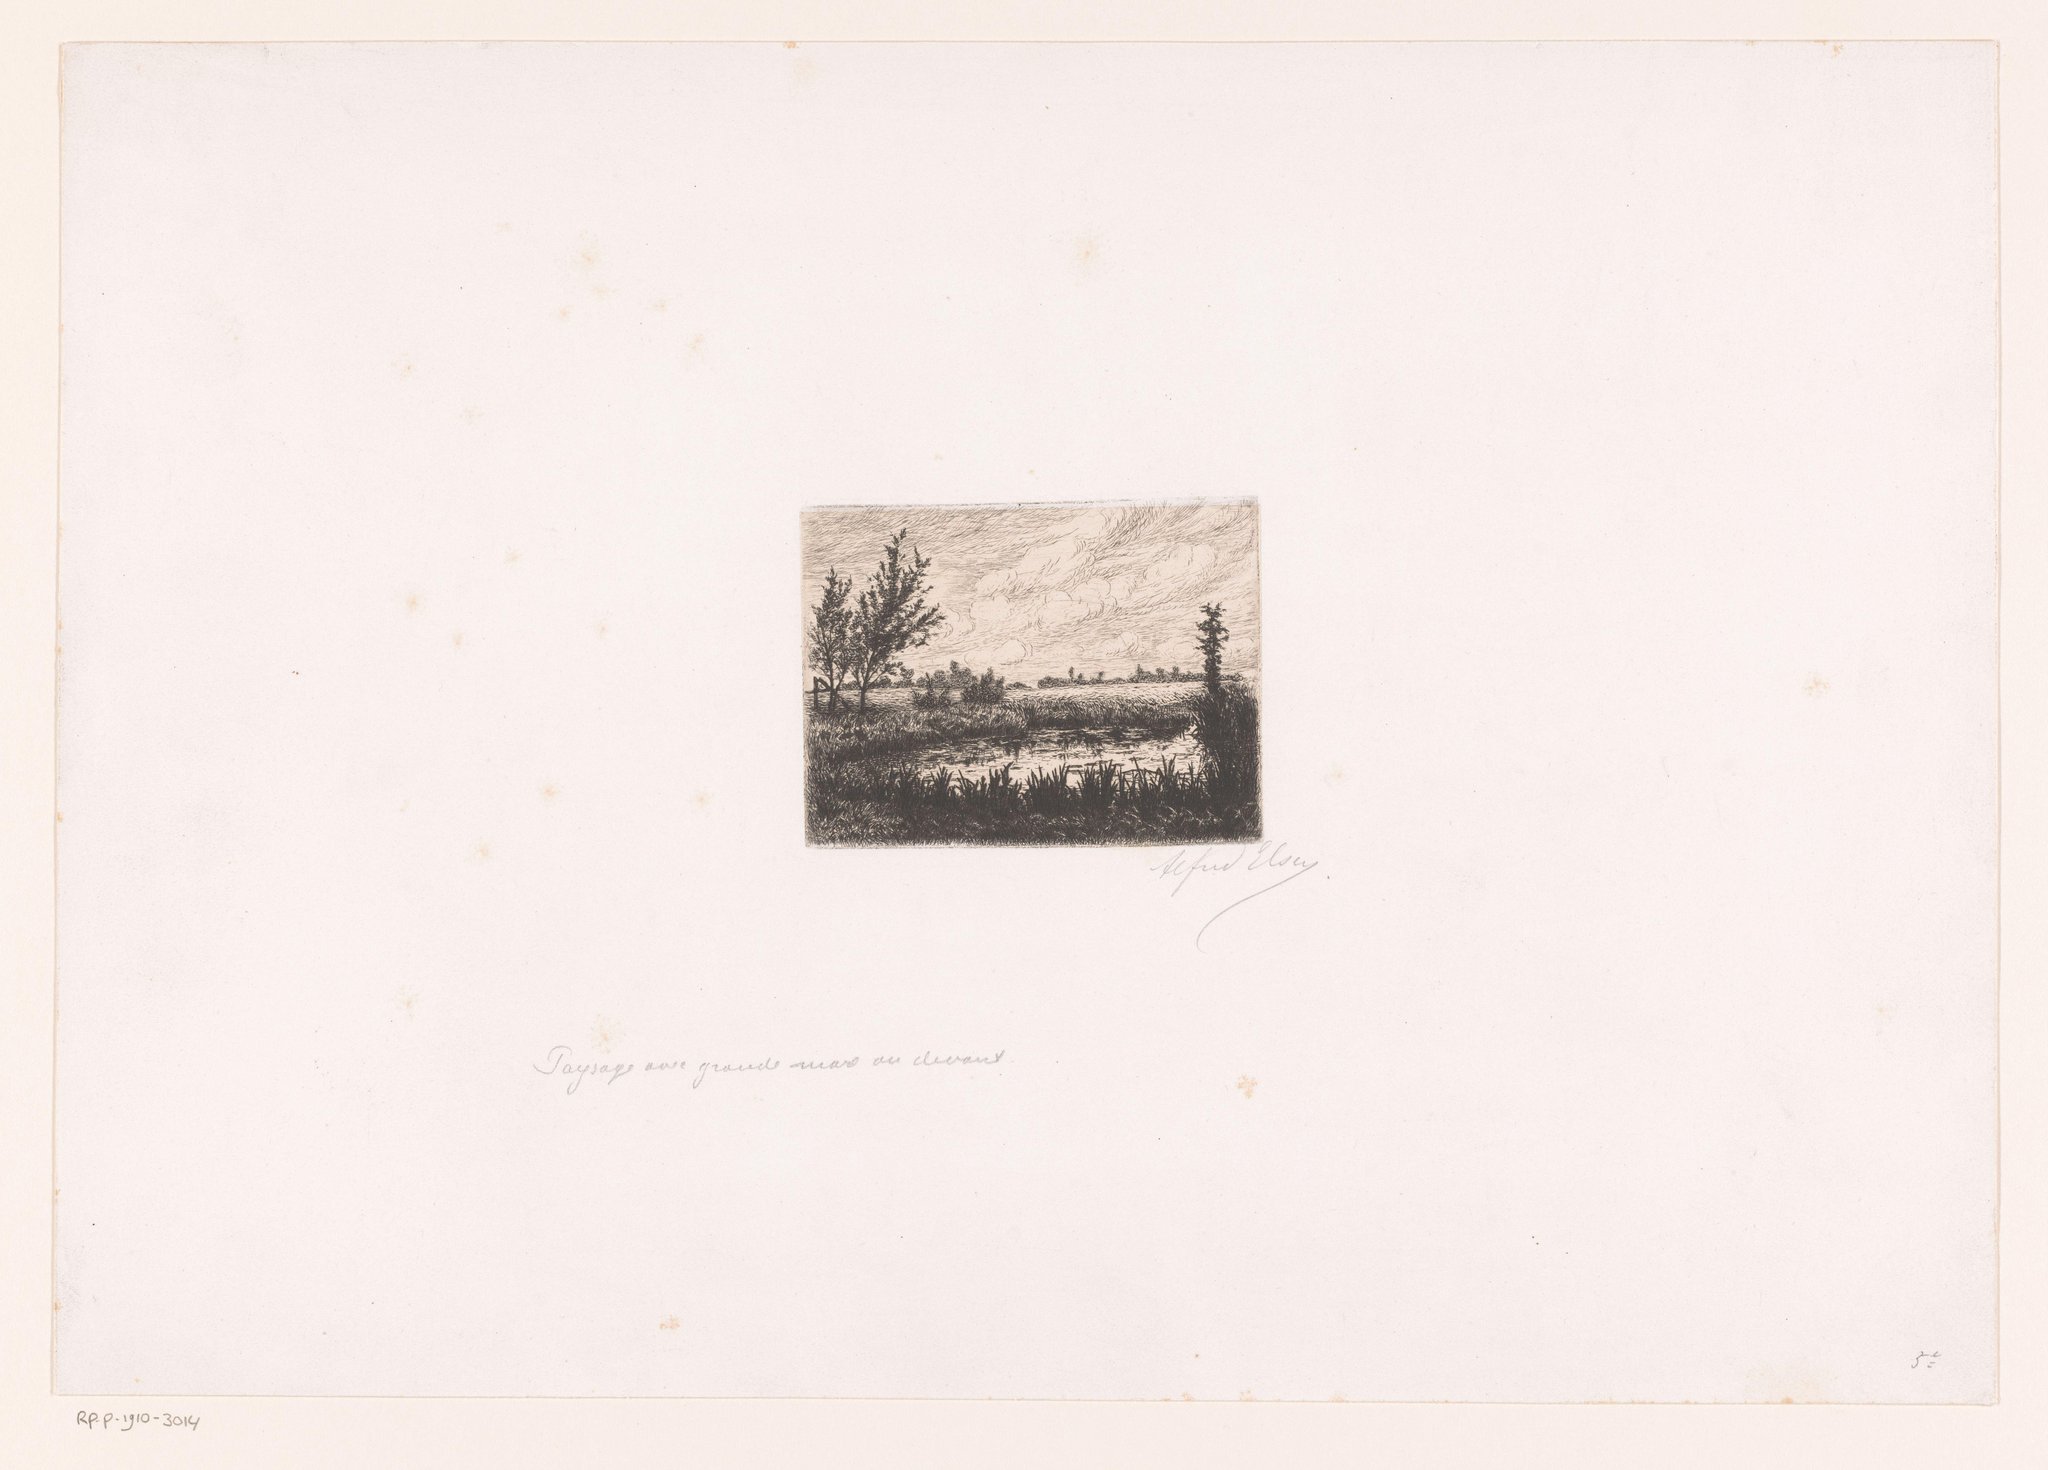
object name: print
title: Landschap met waterplas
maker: alfred elsen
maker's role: painter, print maker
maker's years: 1850-1914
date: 1860-1910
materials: paper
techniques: etching, intaglio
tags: lake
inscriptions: collector's mark: Lugt 2228